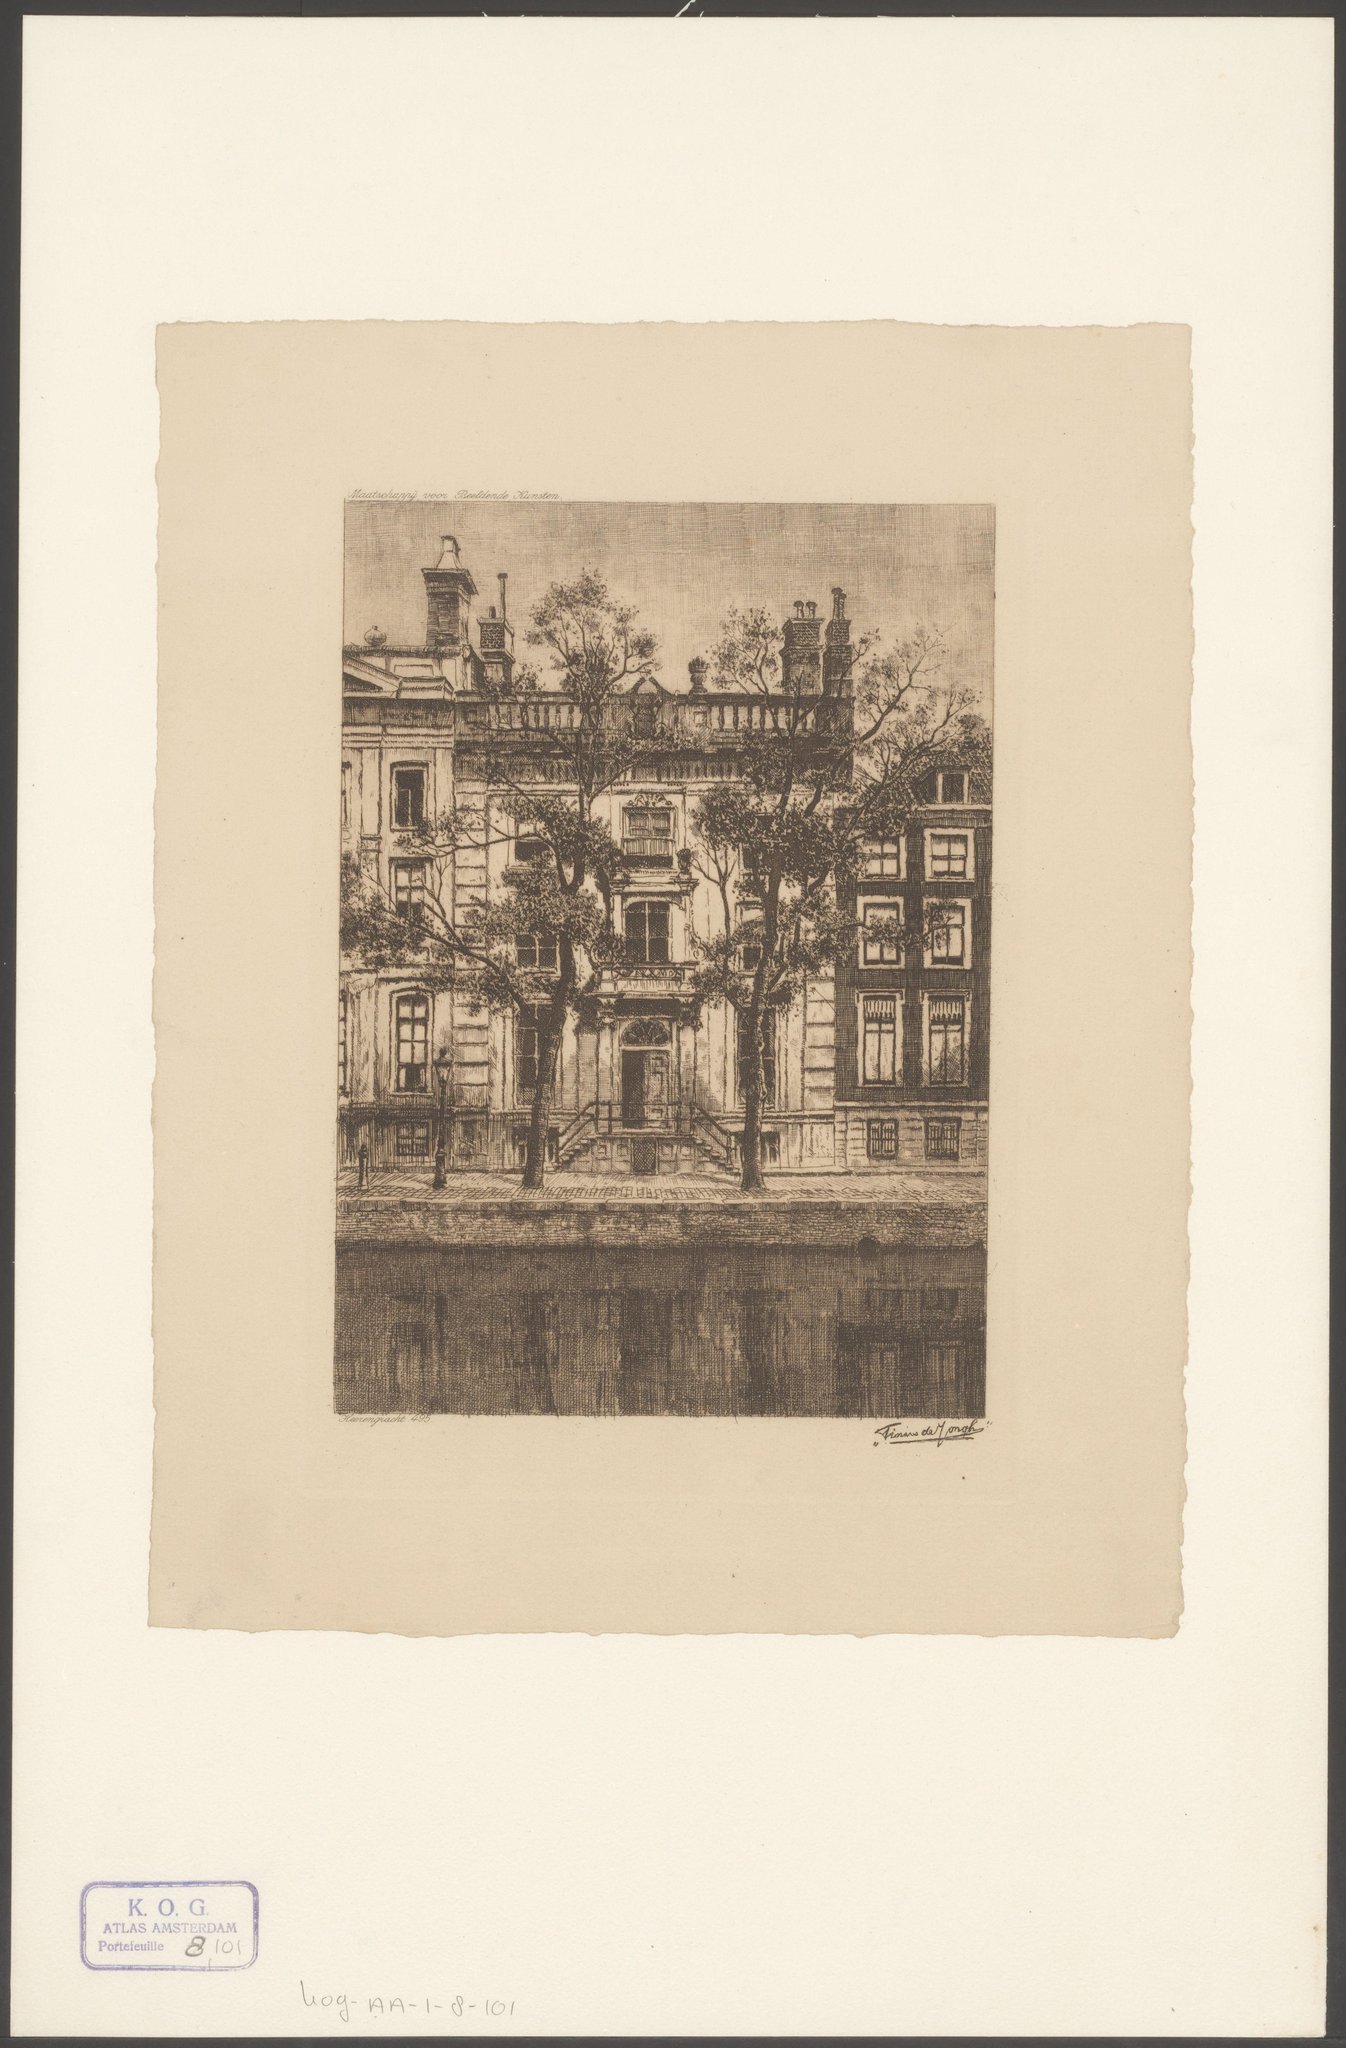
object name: print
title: De Heerengracht / Le Canal dit Heerengracht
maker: tinus de jongh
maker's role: print maker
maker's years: 1885-1942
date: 1918-1942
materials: paper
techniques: etching, intaglio, retroussage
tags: city-view in general; 'veduta', canal, the usual house or row of houses, façade (of house or building), street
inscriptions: collector's mark: ‘8,101’ Lugt 1641b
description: Onderwerpsrubriek binnen de Atlas Amsterdam: Haarlemmerplein, Halvemaansteeg, Handboogstraat, Handelskade, Haringpakkerij, Hartenstraat, Hasseltsteeg (Dirk van), Heerengracht.